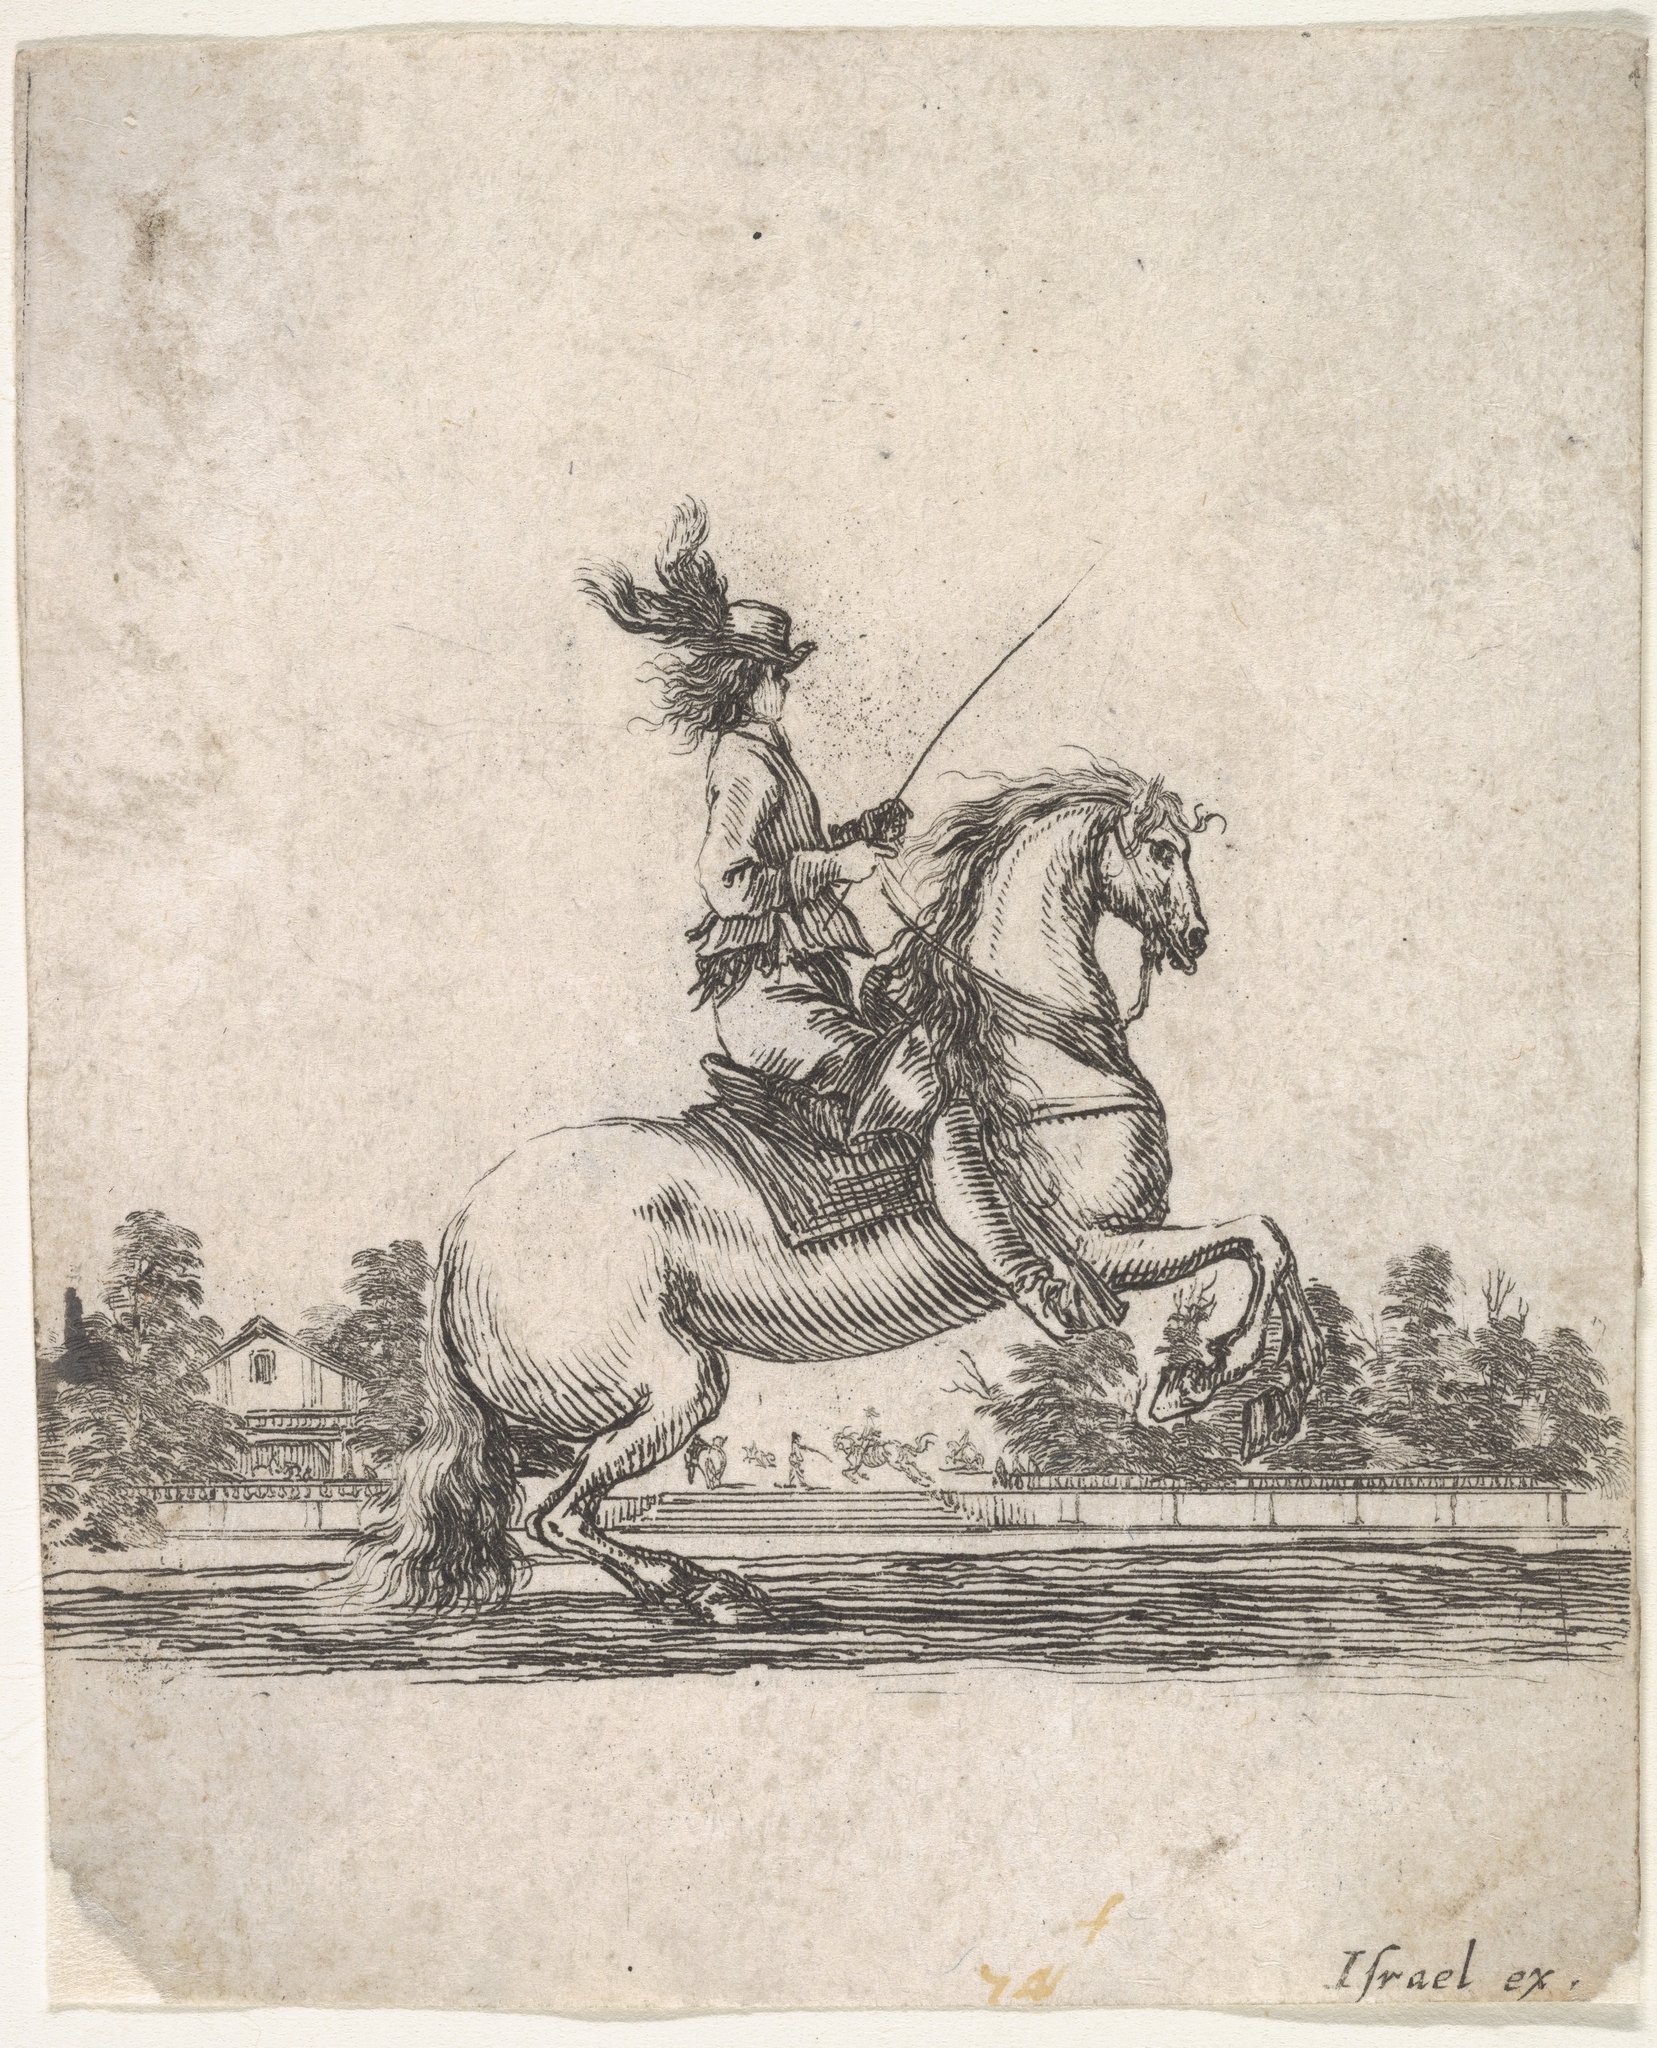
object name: print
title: A horseman atop a rearing horse, in profile and turned towards the right, gardens in the background, from "Various cavalry exercises" (Diverses exercices de cavalerie)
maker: stefano della bella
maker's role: artist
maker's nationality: italian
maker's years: 1610-1664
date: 1642-1645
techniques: etching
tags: men,profiles,horses